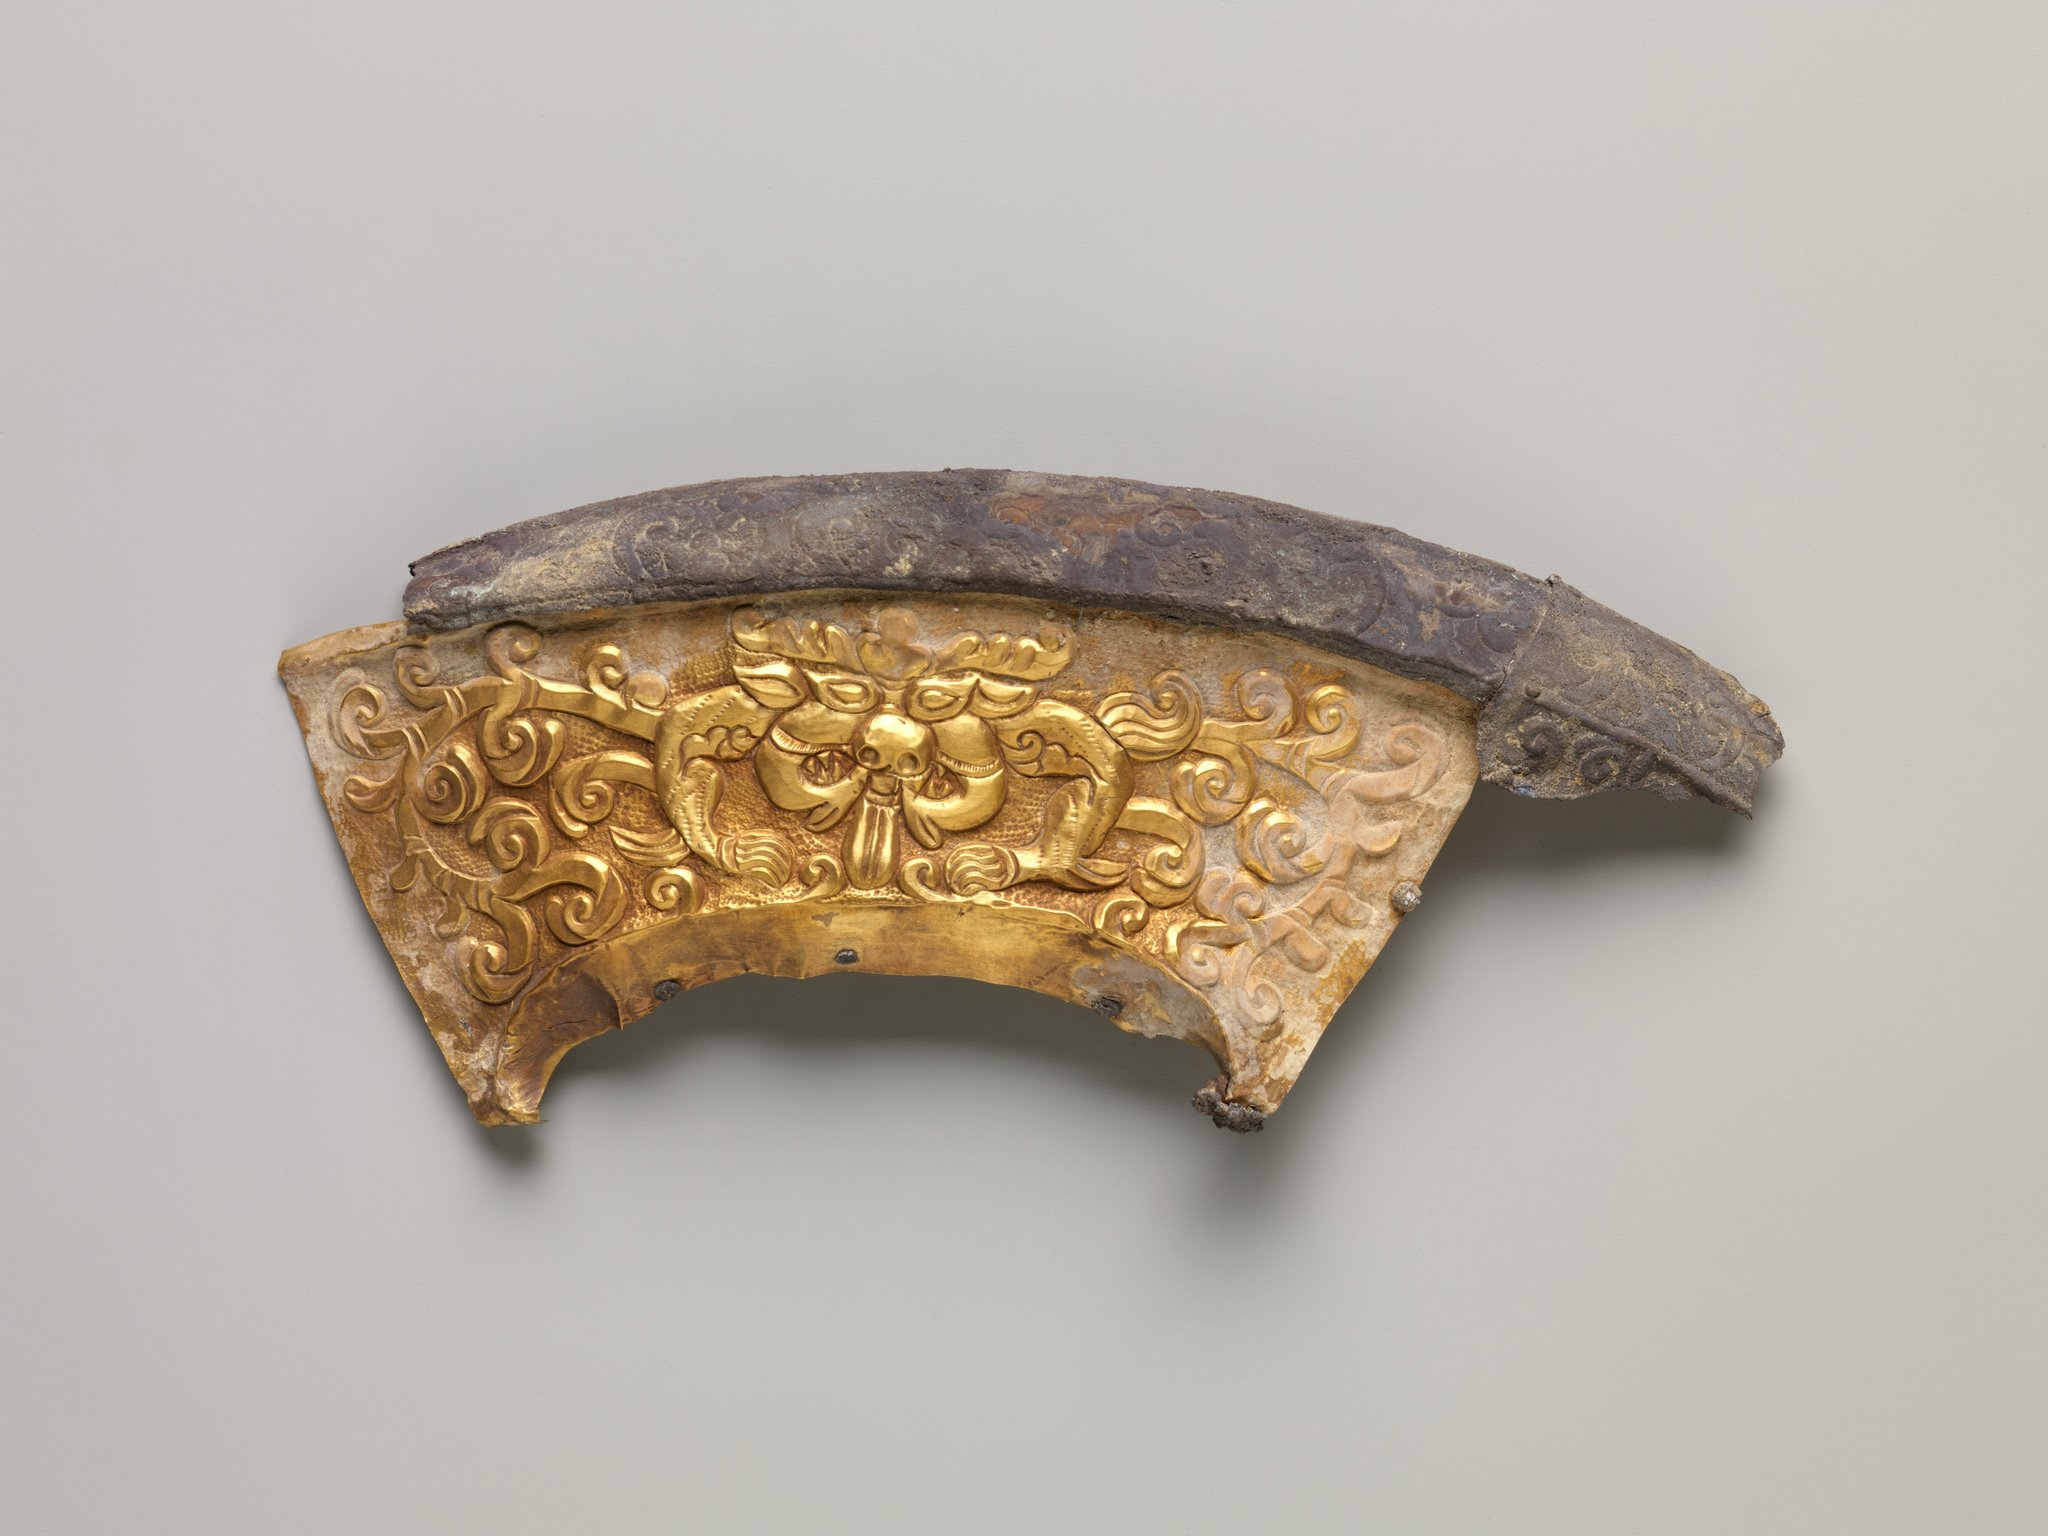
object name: saddle fitting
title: Saddle Pommel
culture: chinese or central asian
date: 601-900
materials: gold foil, silver